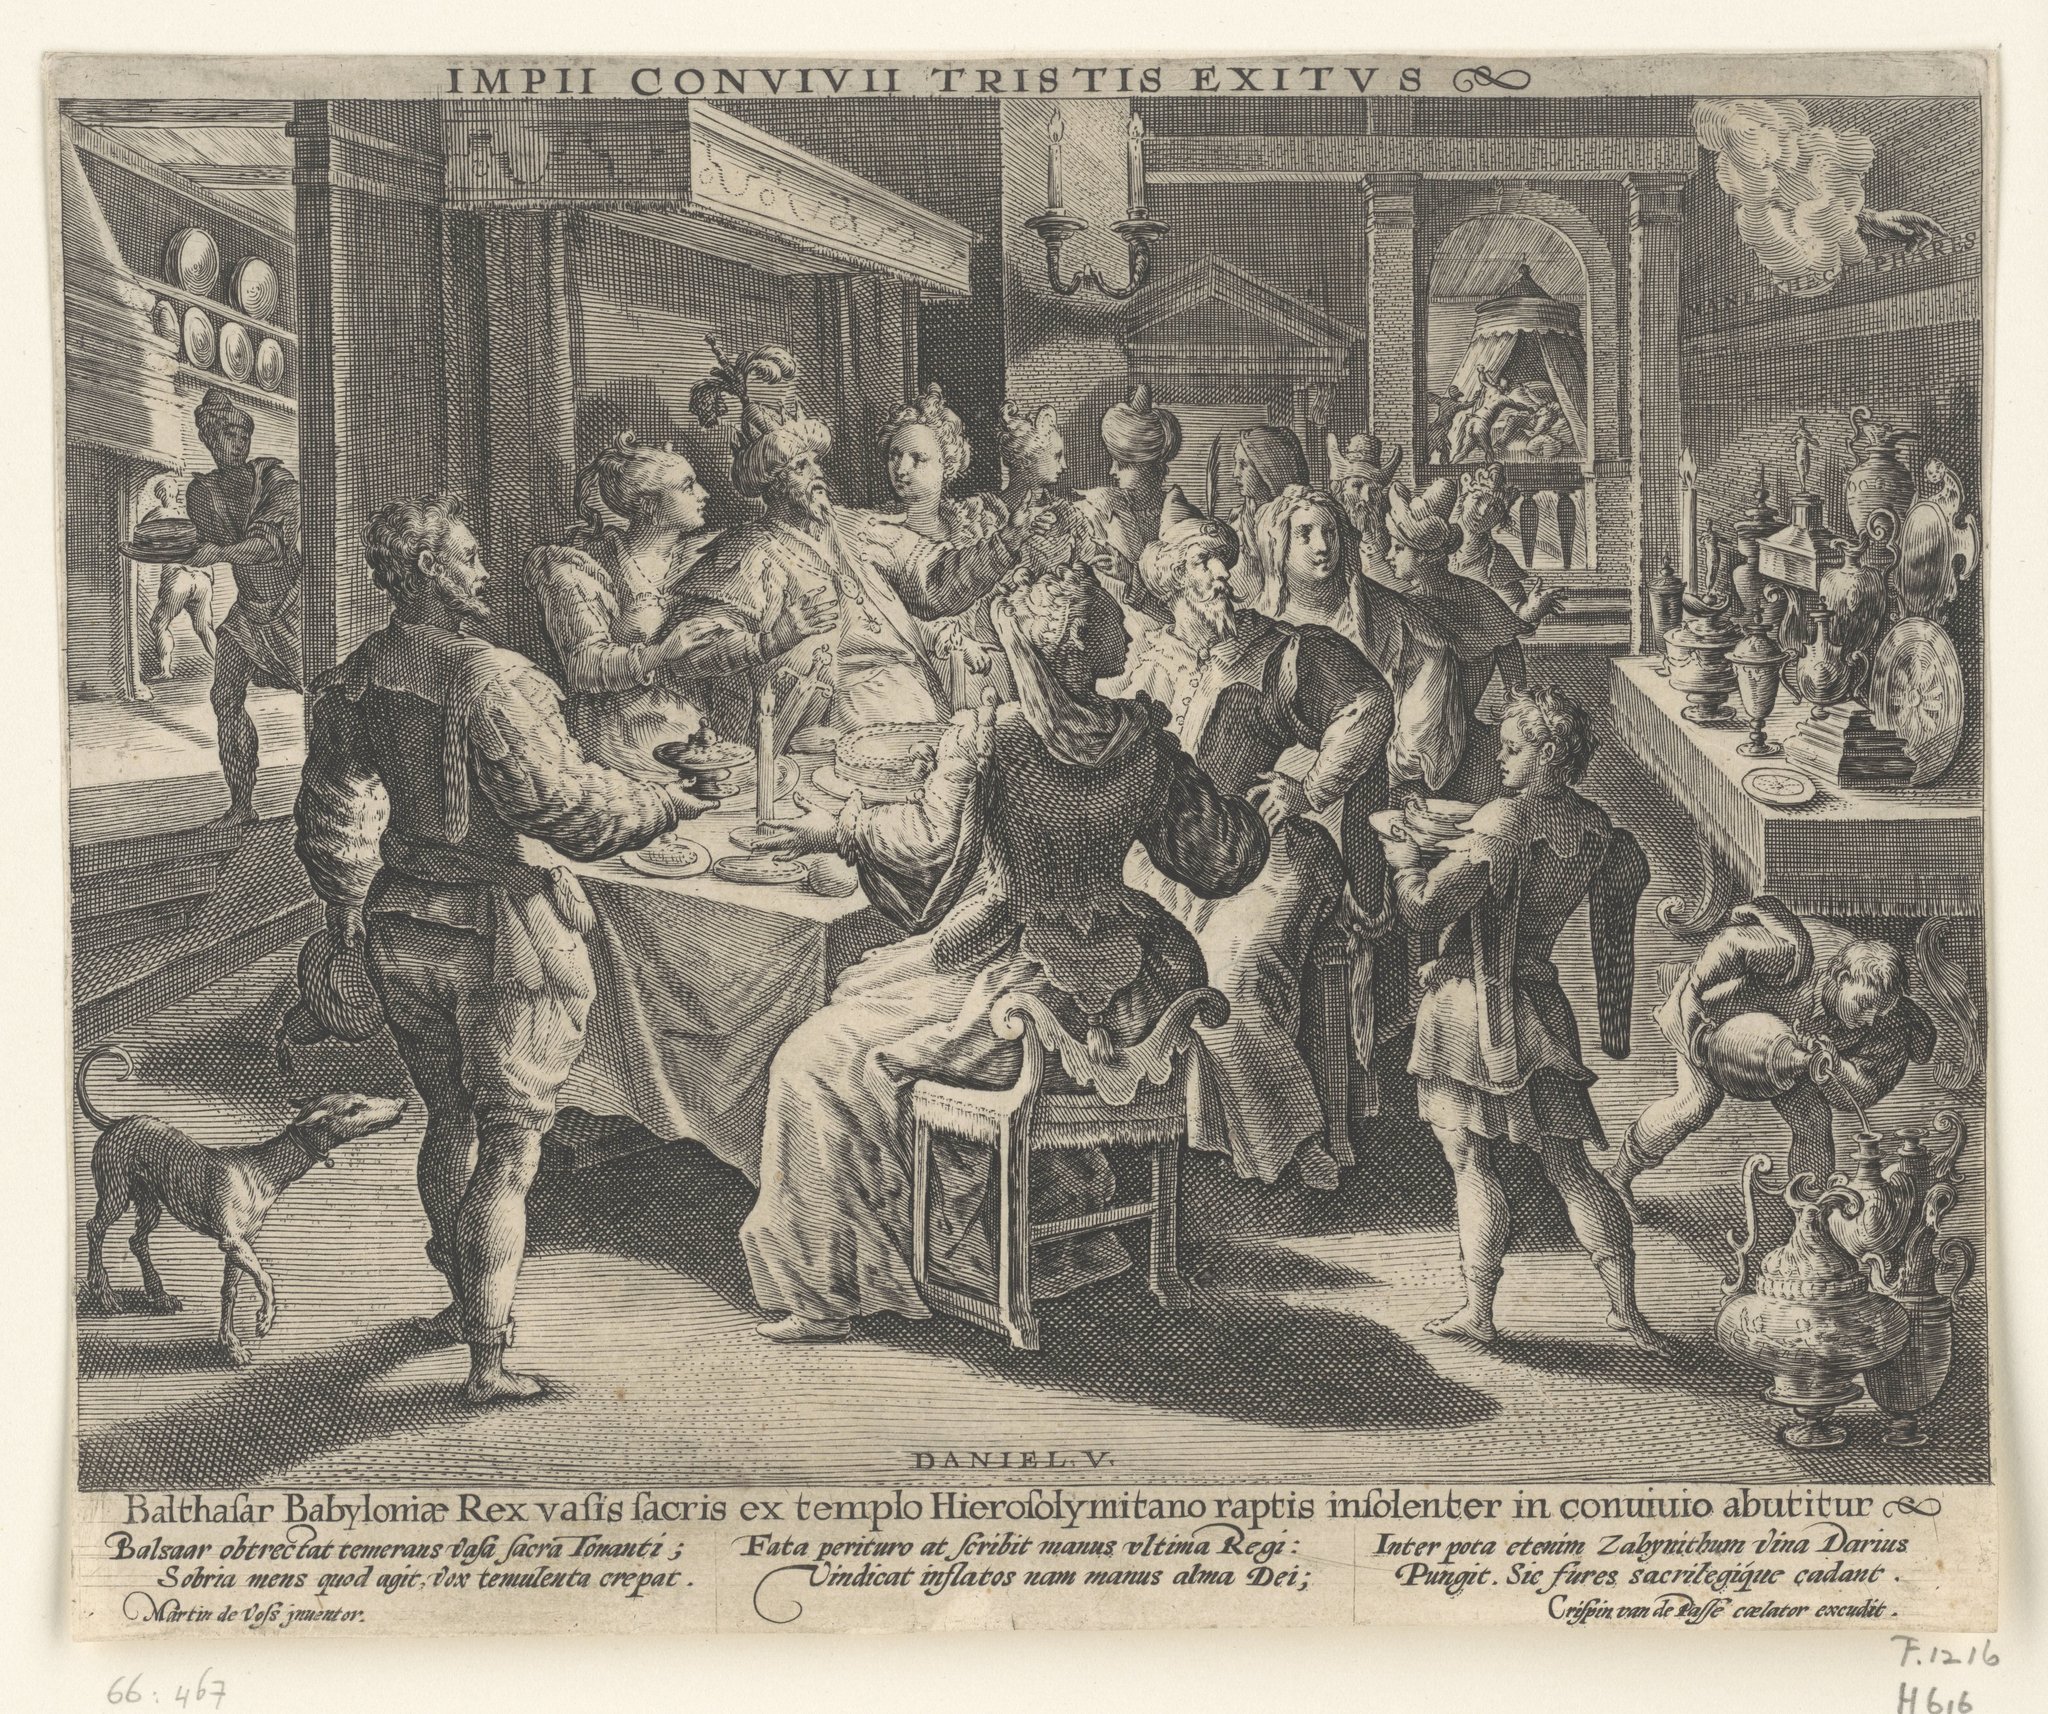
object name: print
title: Impii Convivii Tristis Exitvs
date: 1580-1588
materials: paper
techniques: engraving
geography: antwerp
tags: death of king belshazzar, during belshazzar's banquet a hand appears and writes on the wall (mene, mene, tekel and parsin (upharsin)); king belshazzar is frightened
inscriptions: collector's mark: Lugt 1041c, collector's mark: Lugt 2228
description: Het feestmaal van Belsassar, de koning van de Chaldeeën, als allegorie op de zondige maaltijd. De koning en zijn gezelschap drinken op heidense goden uit bekers die uit de tempel van Salomo zijn gestolen. Dan verschijnt er een mensenhand die op de muur schrijft en de koning angst aanjaagt. Op de achtergrond de moord op Belsassar. In de marge een regel en een zesregelig onderschrift, in drie kolommen, in het Latijn die het voorgestelde toelichten.